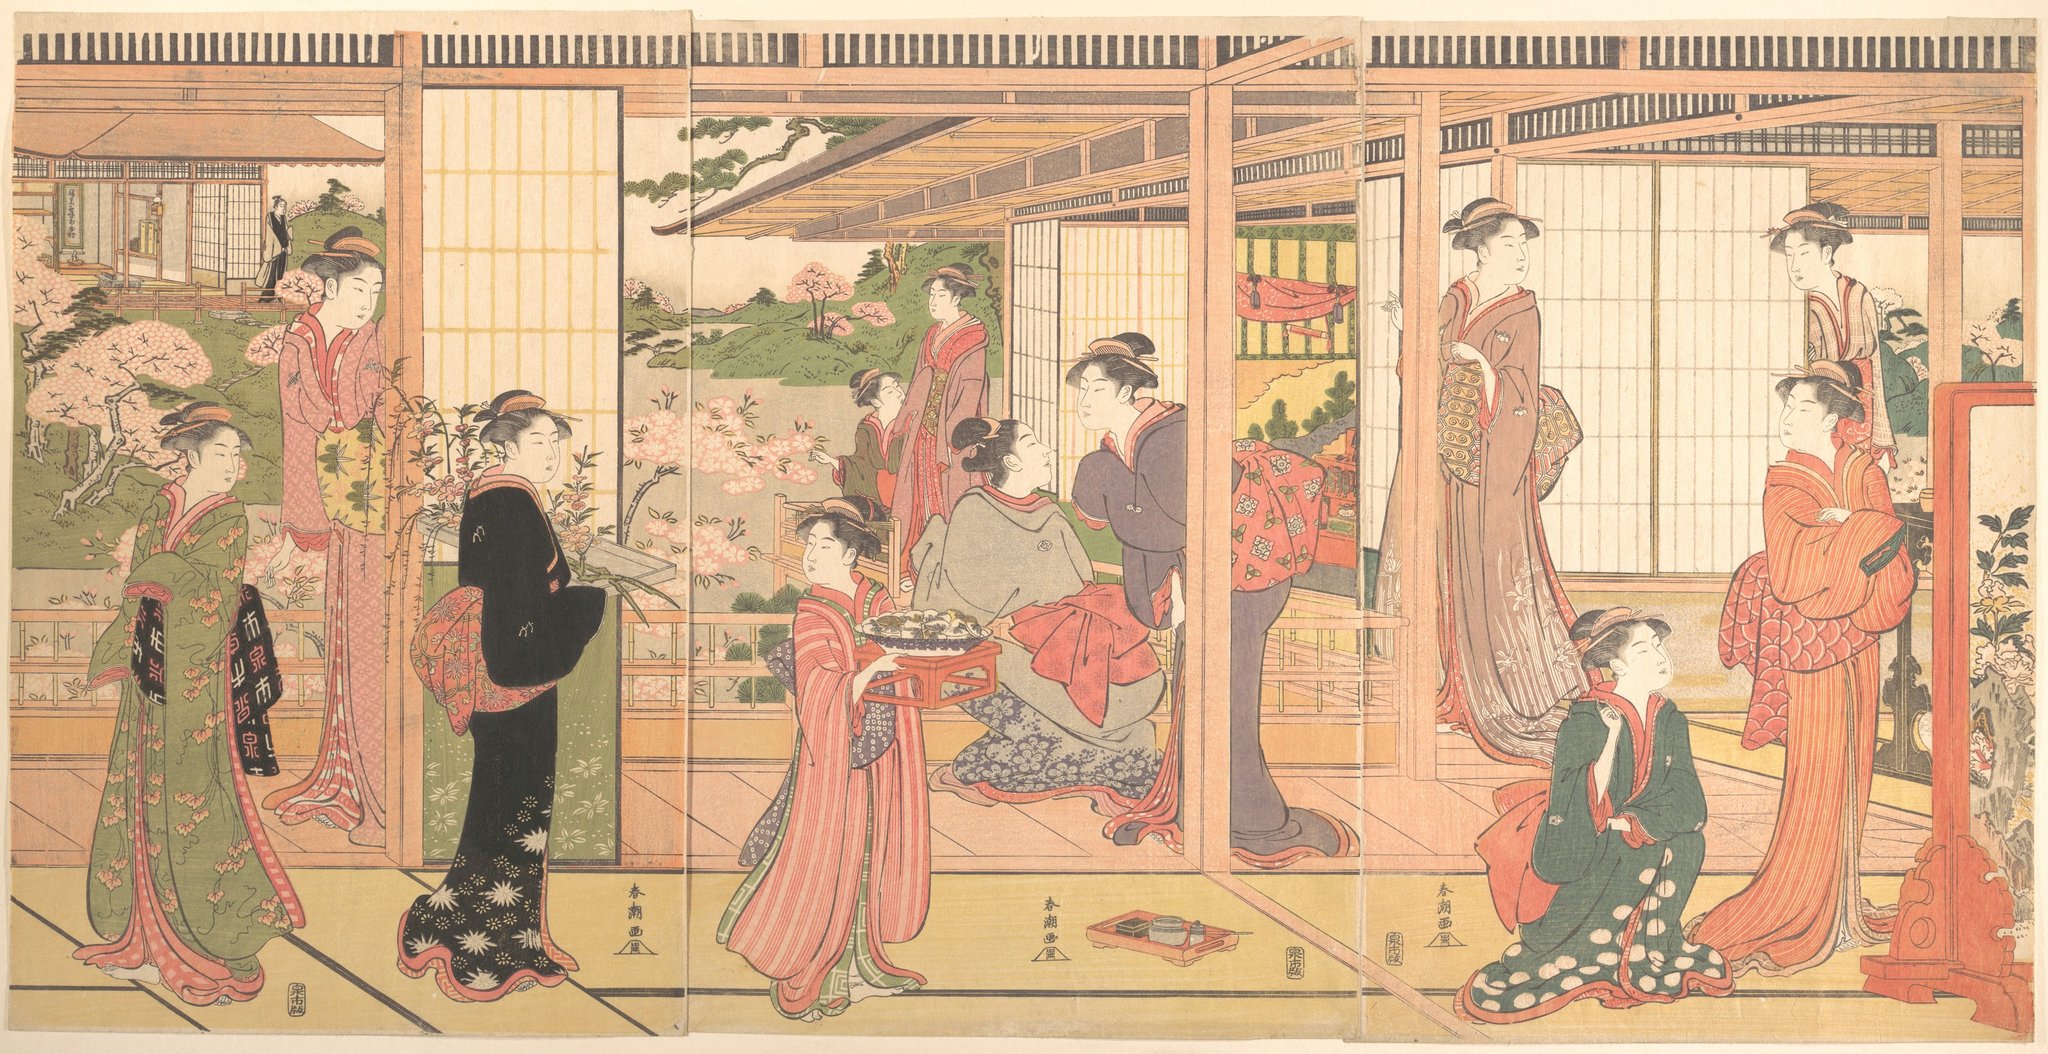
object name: print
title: Mansion Opening onto a Garden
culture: japanese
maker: katsukawa shunchō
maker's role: artist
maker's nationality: japanese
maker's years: 1775-1795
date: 1786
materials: ink, paper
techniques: woodblock print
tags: gardens,women